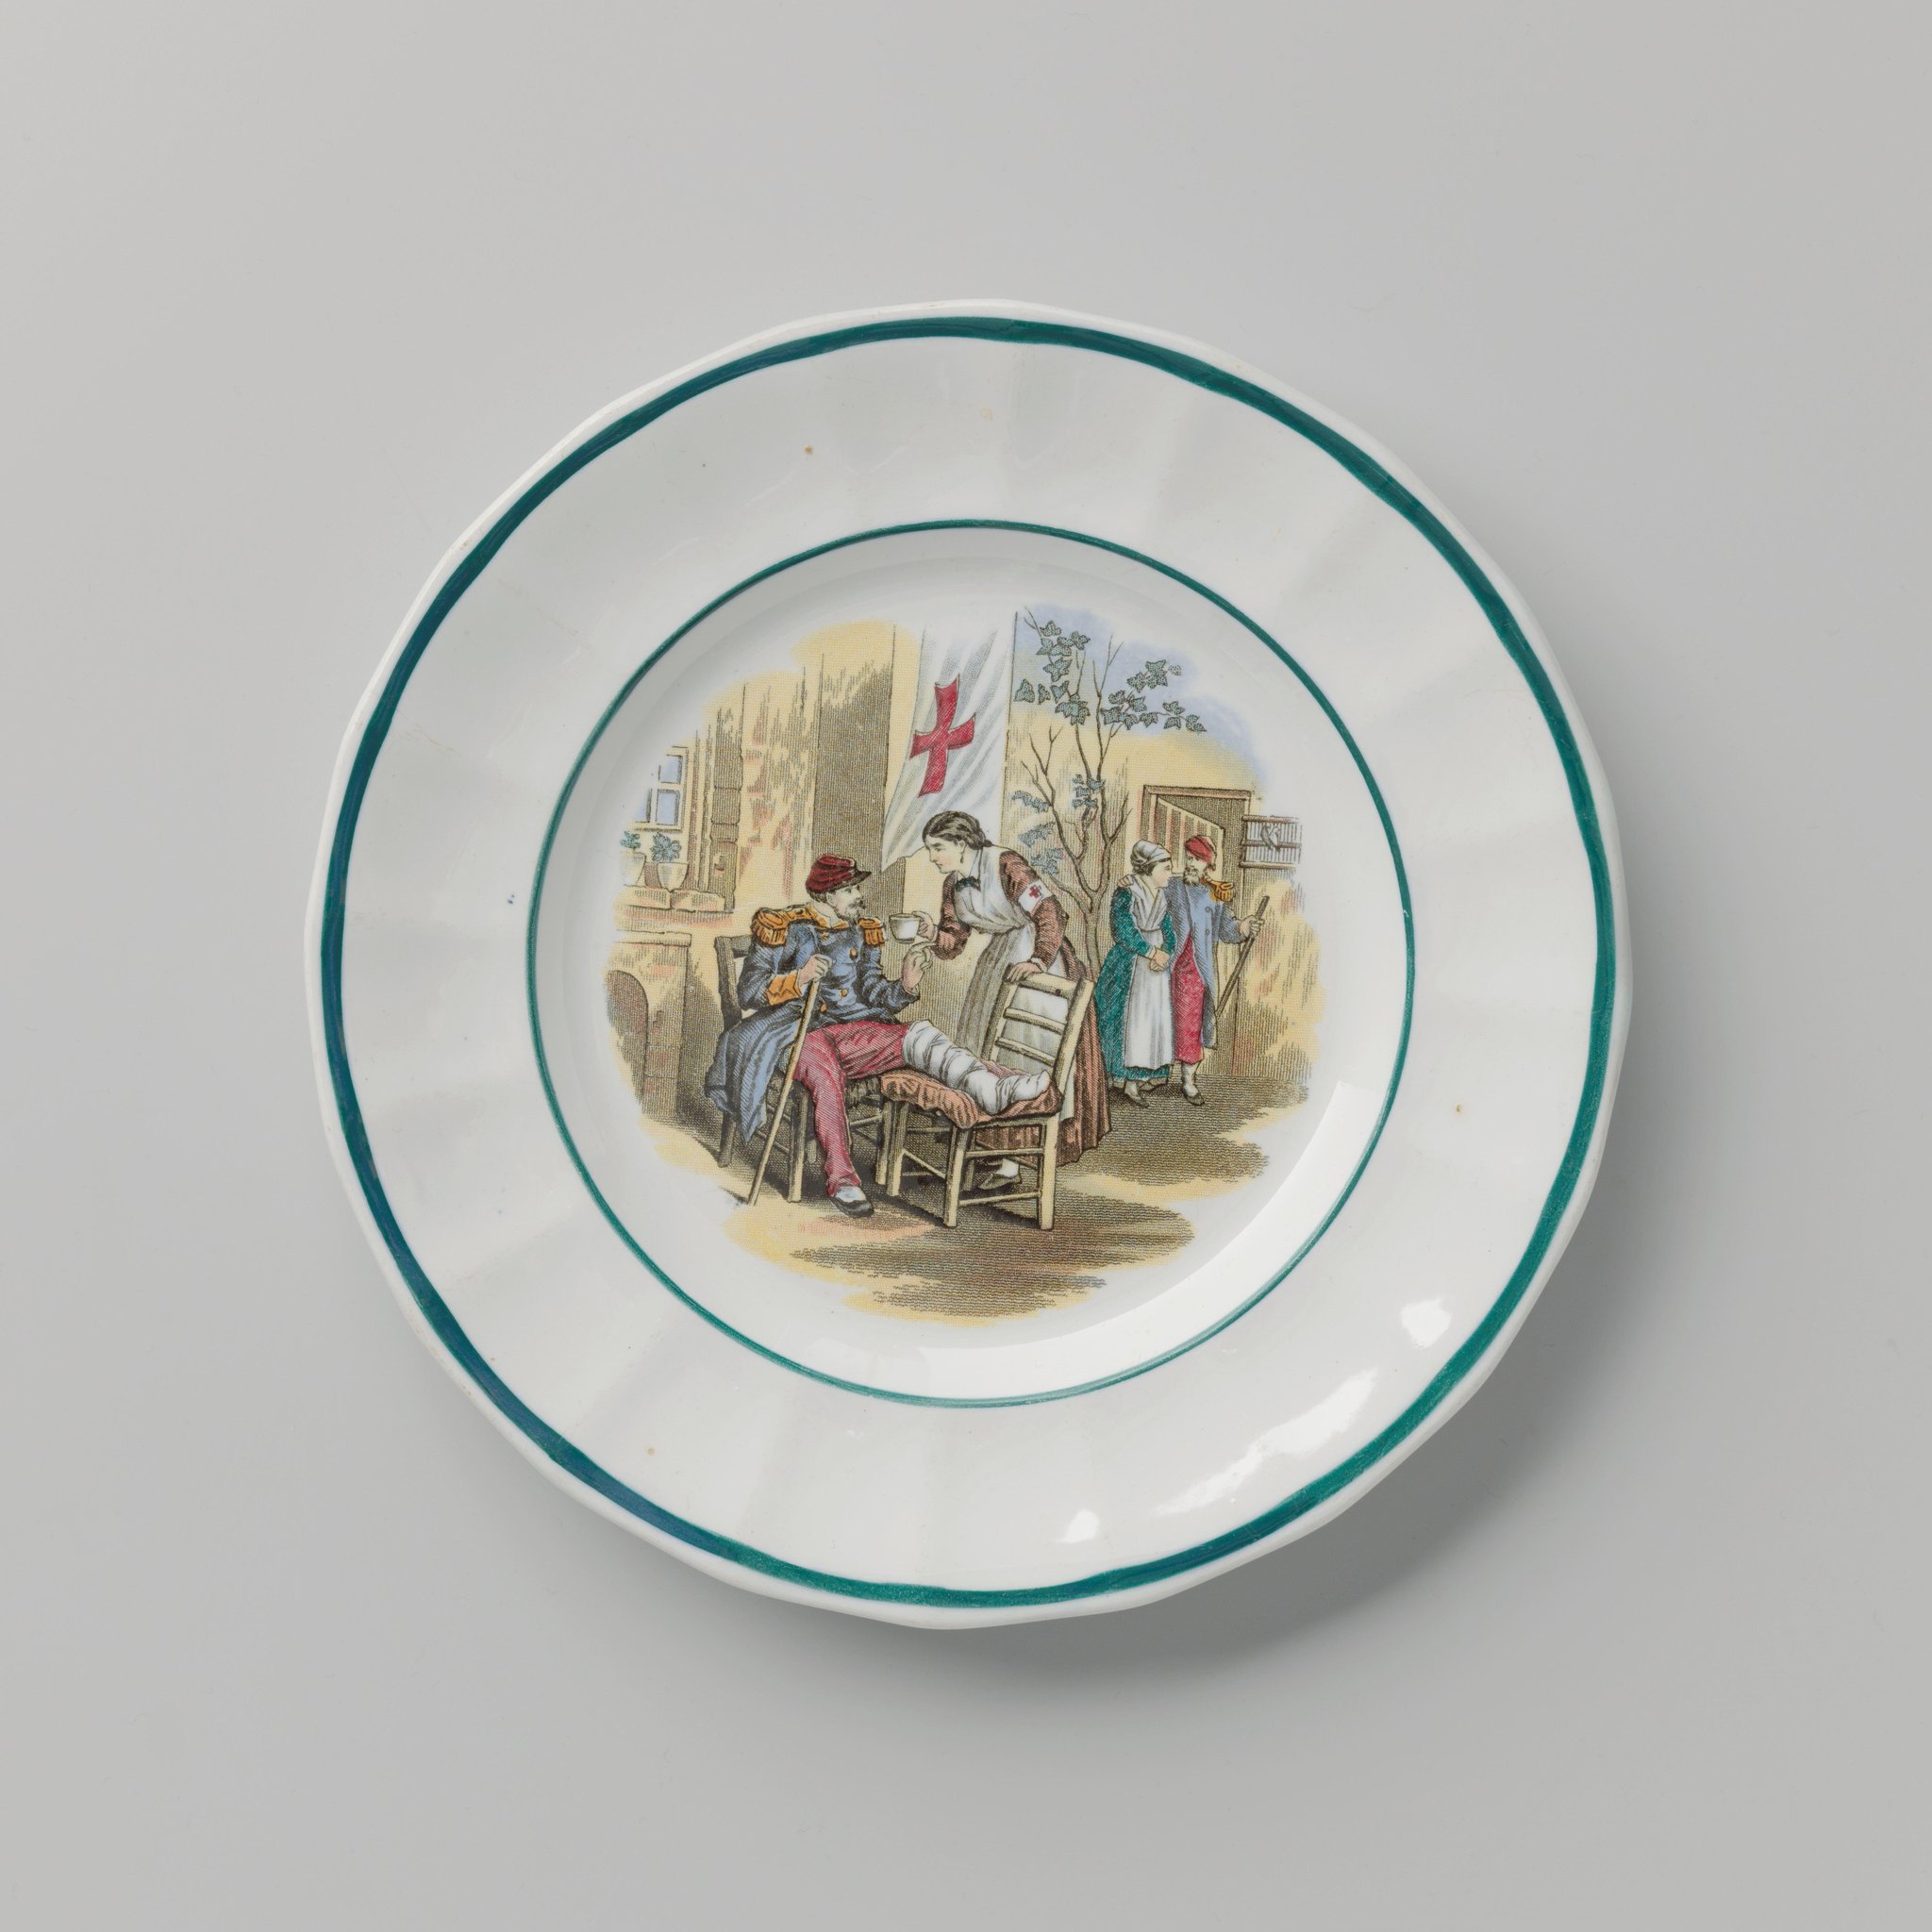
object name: plate dish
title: Bord, met op het plat een rodekruispost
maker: petrus regout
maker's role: plateelbakker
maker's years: 1801-1879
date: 1860-1890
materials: creamware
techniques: transfer decoration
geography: maastricht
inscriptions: check stamp: ‘Bijenkorf // P. REGOUT // MAASTRICHT // 17’, mark: ‘PETRUS REGOUT // (een rood kruis) // MAASTRICHT’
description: Bord van aardewerk met veelkleurig transferdecor. Op het plat een rodekruispost. Links op een stoel zit een soldaat met zijn linkerbeen in het verband. Hij wordt verzorgd door een zuster. Rechts op de achtergrond ondersteunt een tweede zuster een andere soldaat, die met een stok probeert te lopen.